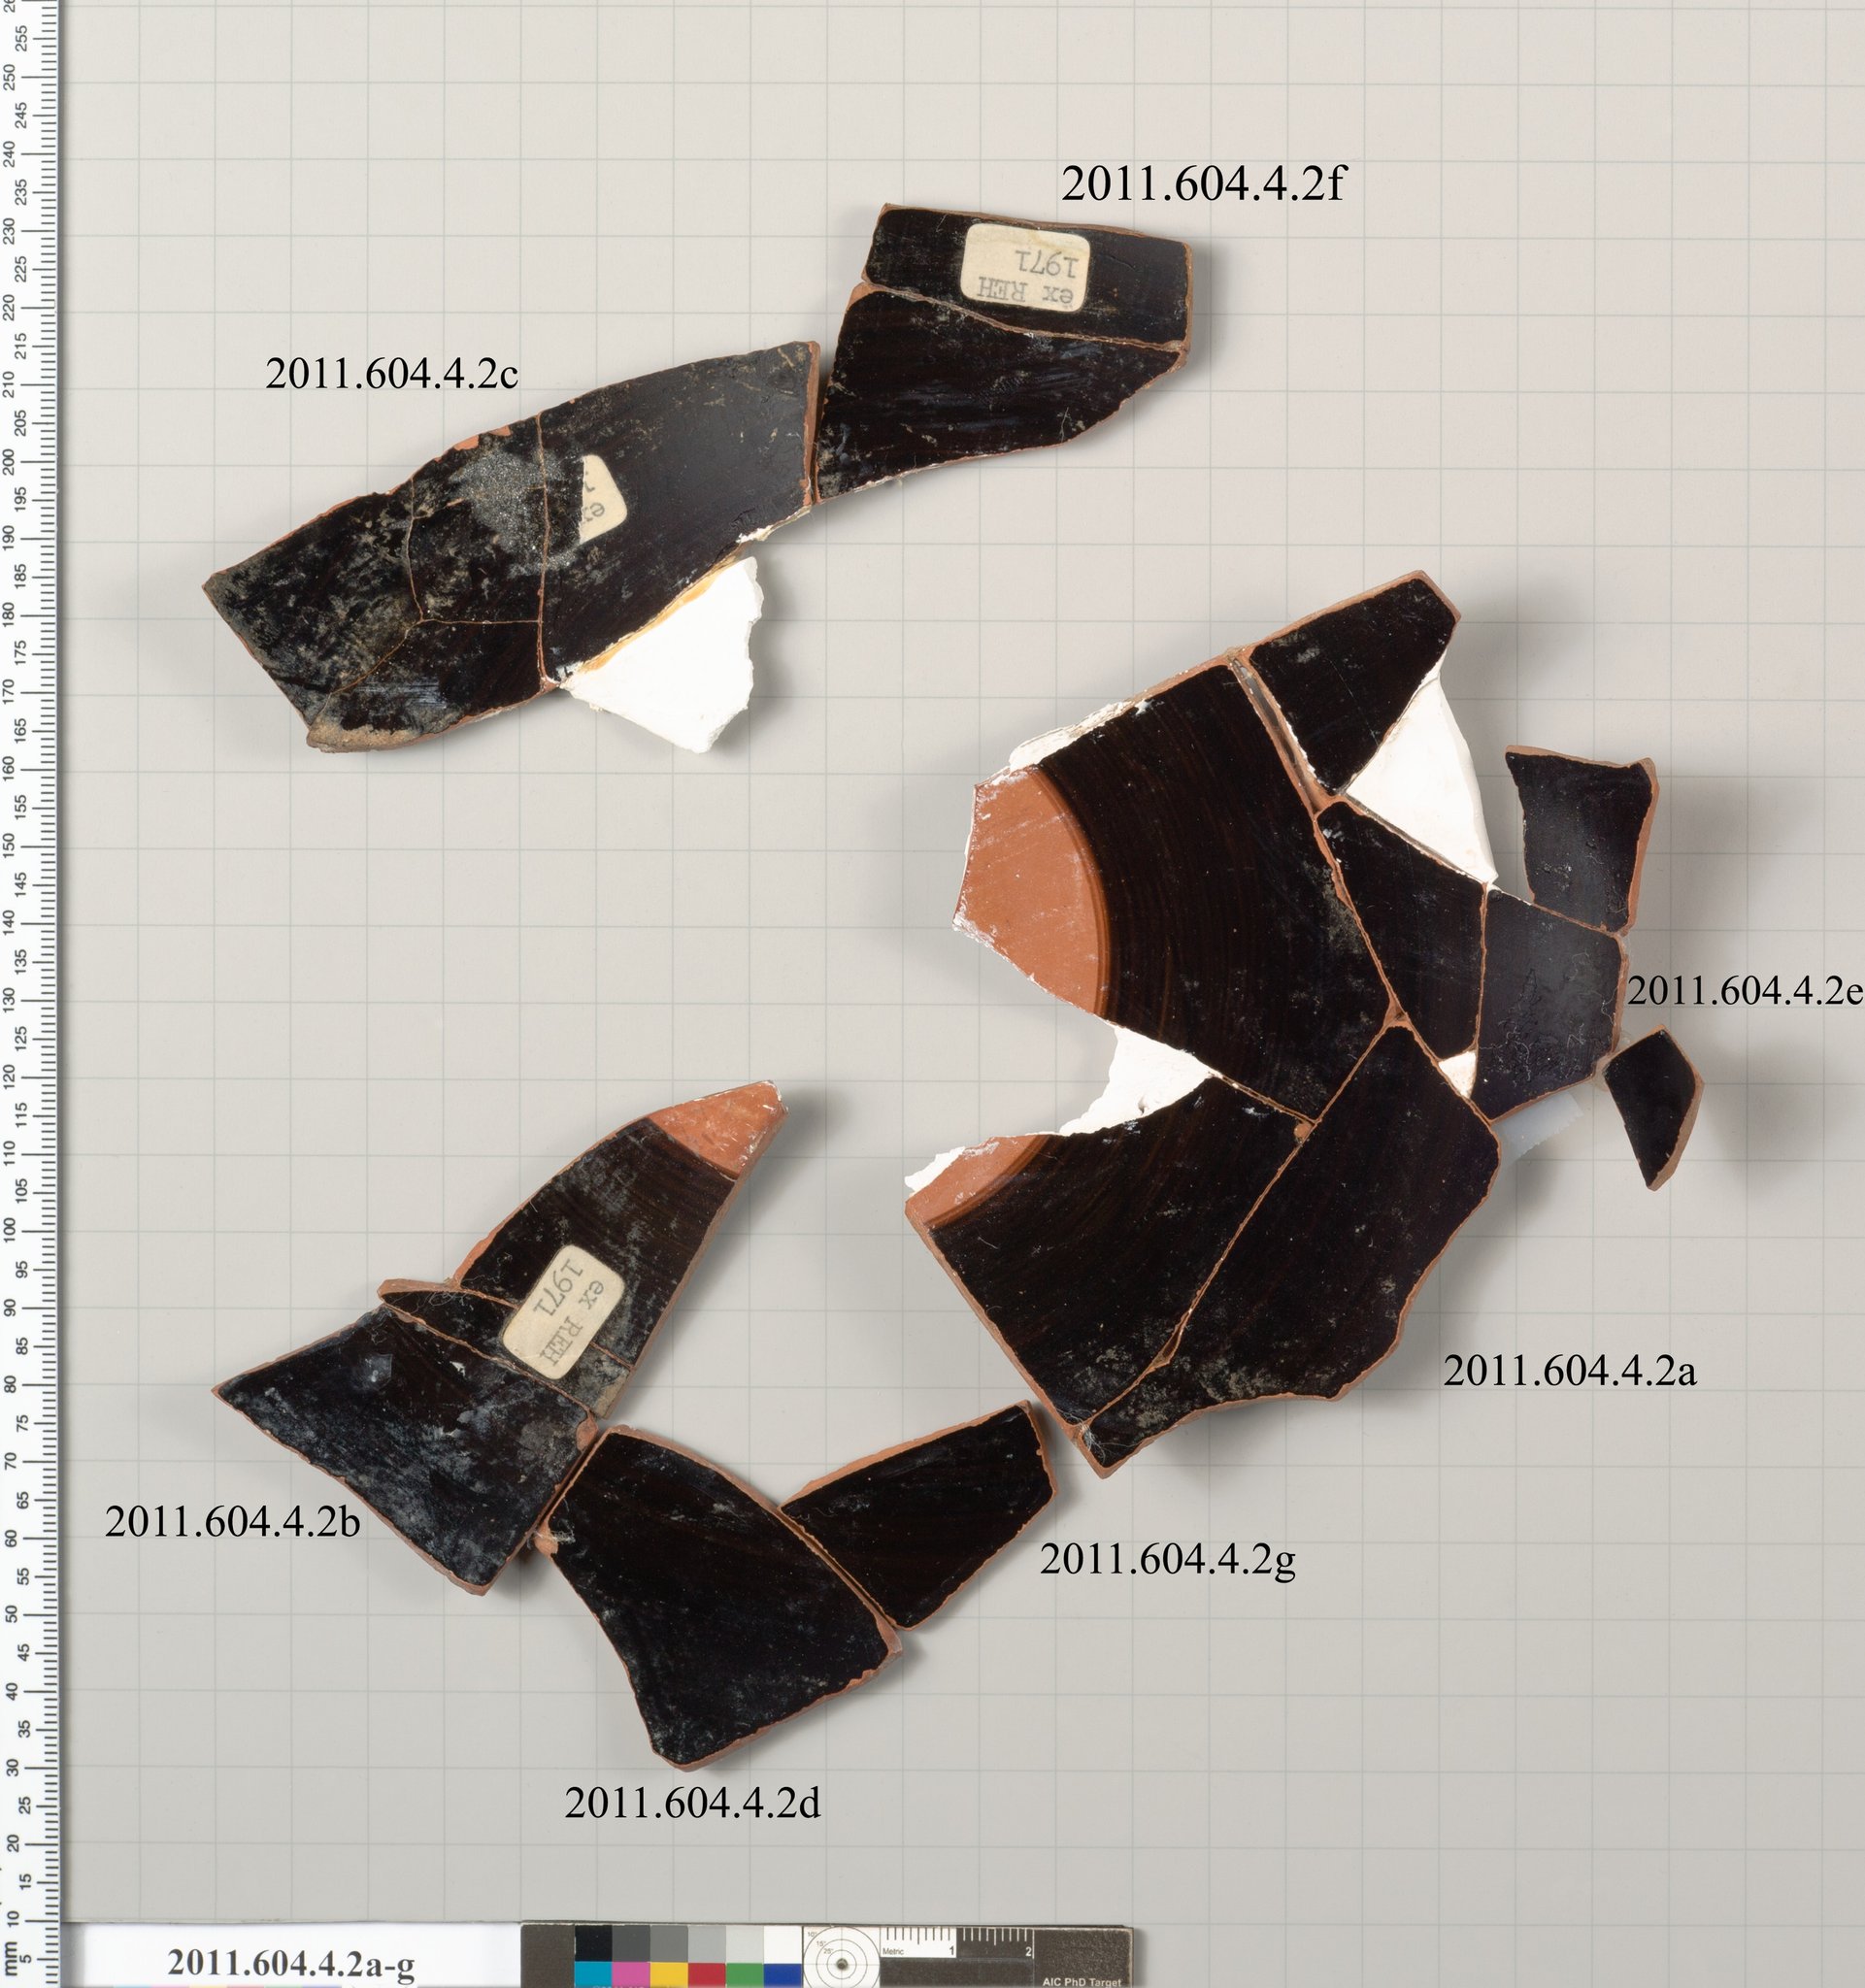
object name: kylix fragment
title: Terracotta fragments of a kylix: band-cup (drinking cup)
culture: greek, attic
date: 550-526 BCE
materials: terracotta